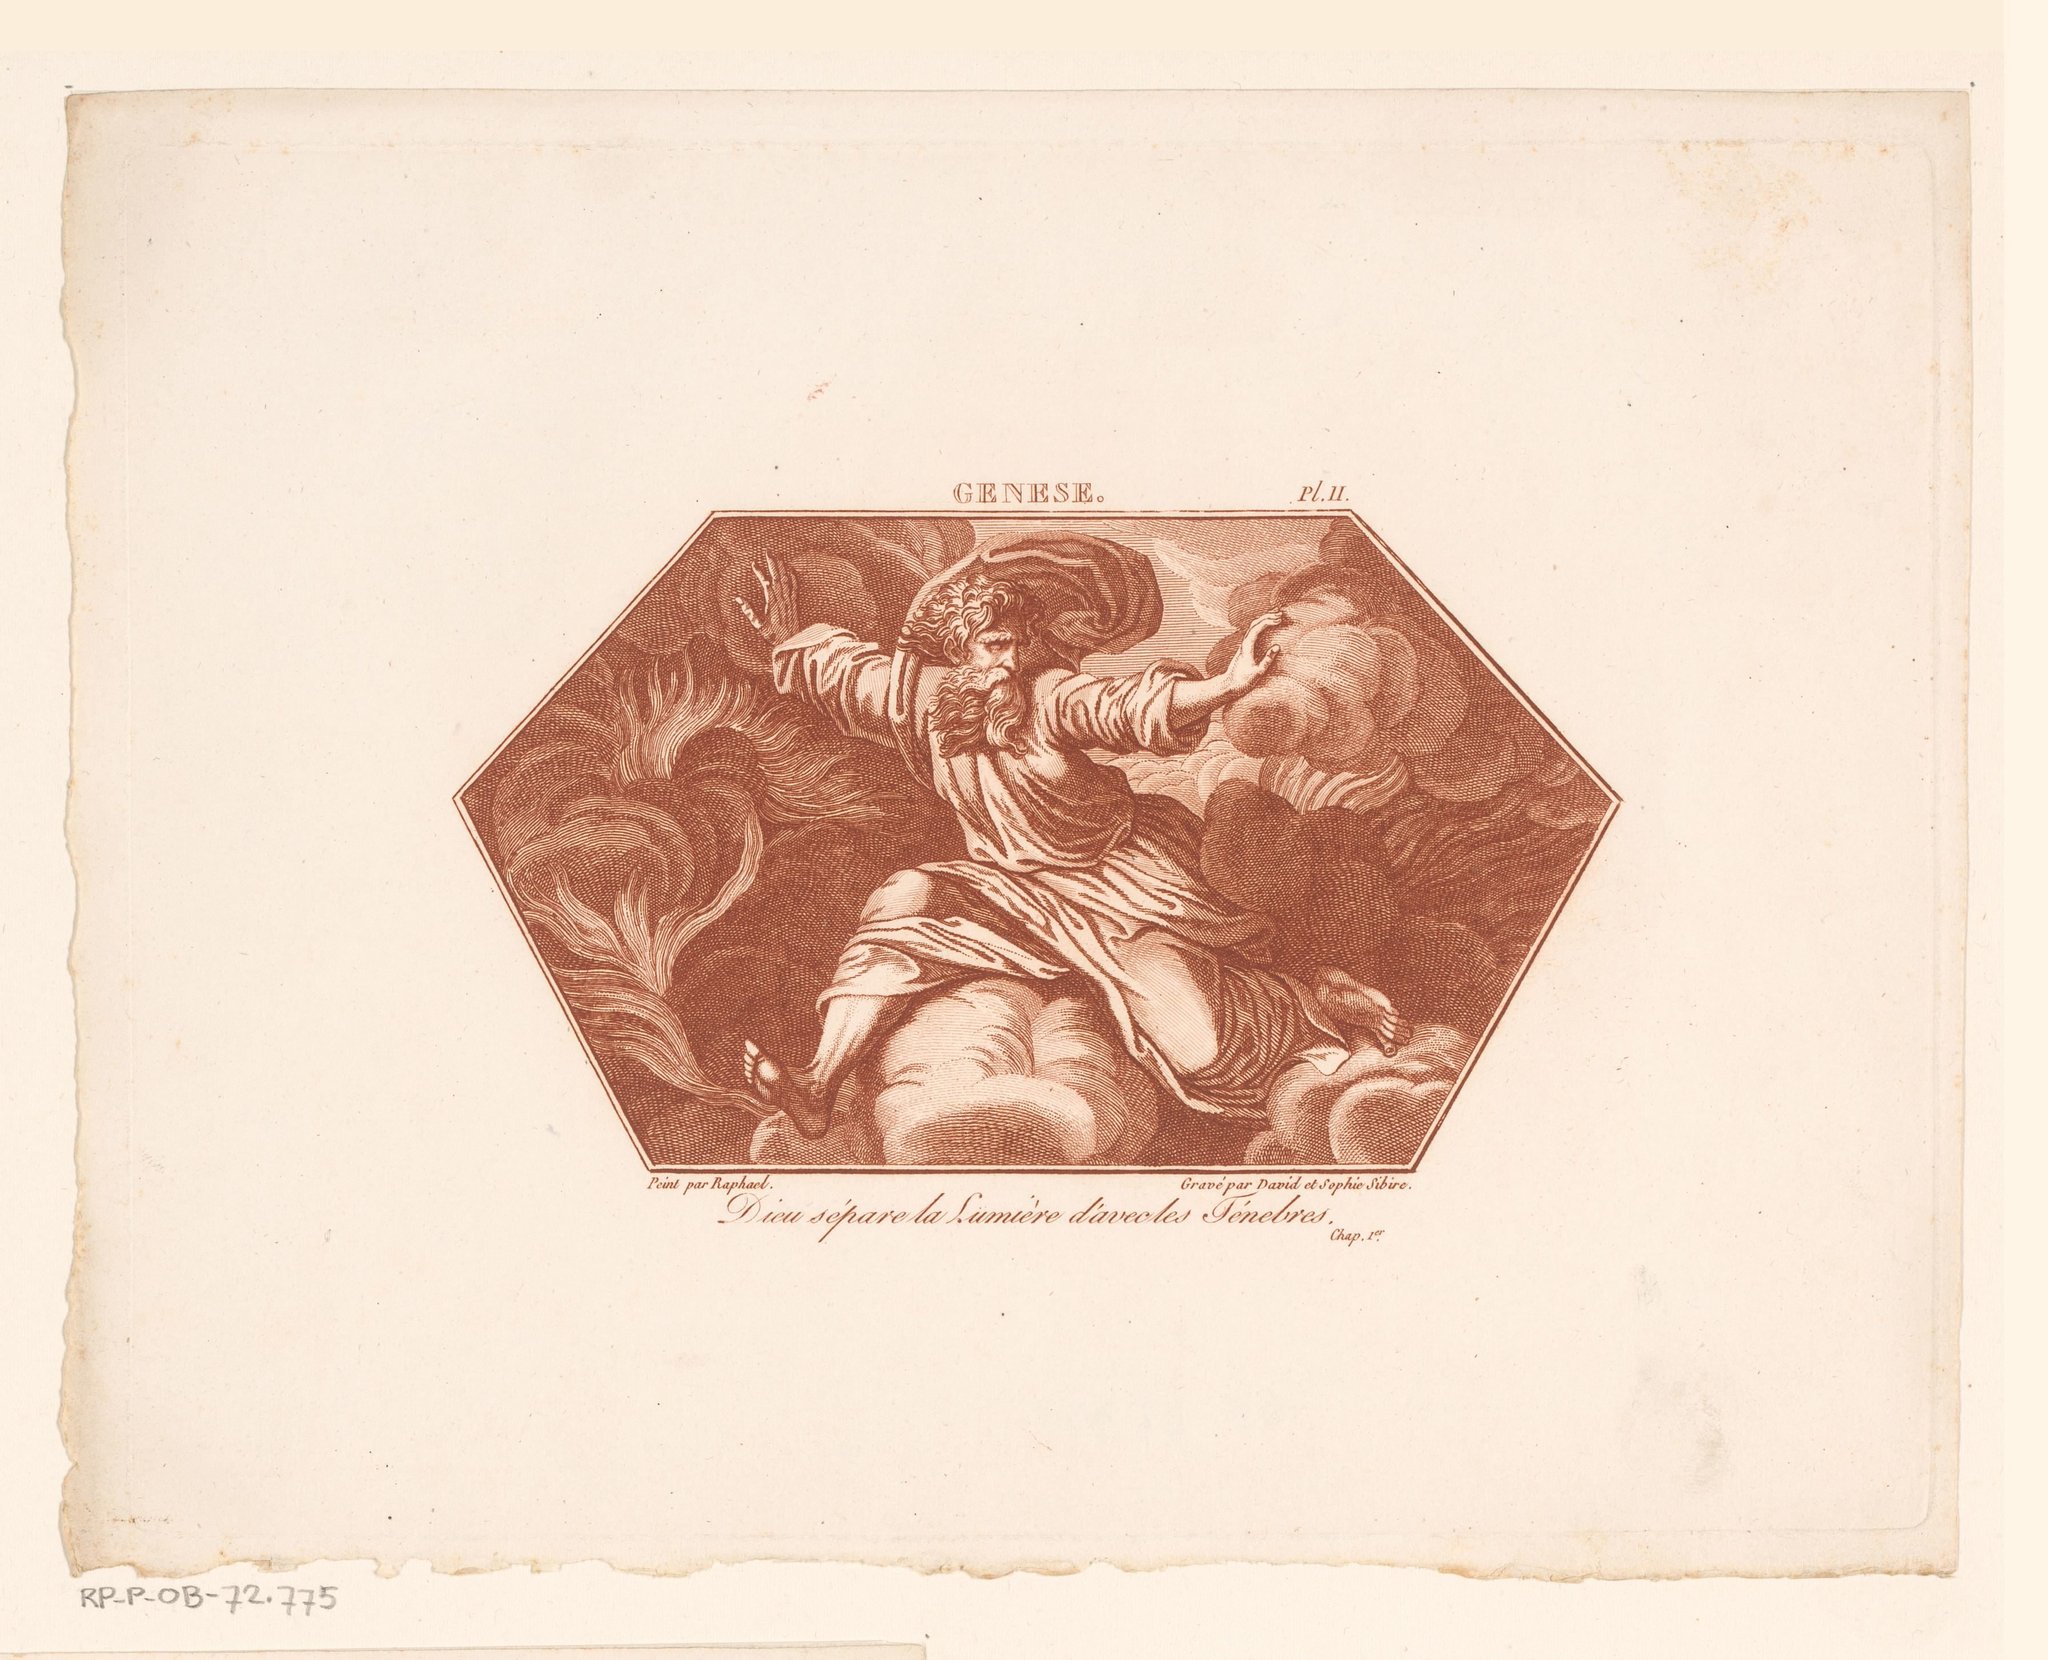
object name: book illustration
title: Dieu sépare la Lumière d'avecles Ténebres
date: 1808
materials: paper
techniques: engraving, etching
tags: division of light and darkness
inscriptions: collector's mark: Lugt 3937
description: Prent uit: Les Loges du Vatican, gravées par David et Mlle Sibire, son élève, d'après cinquante-deux tableaux de Raphael; accompagnées du texte explicatif de la Sainte-Bible. Parijs: François Anne David en Georges Leblanc, 1808.